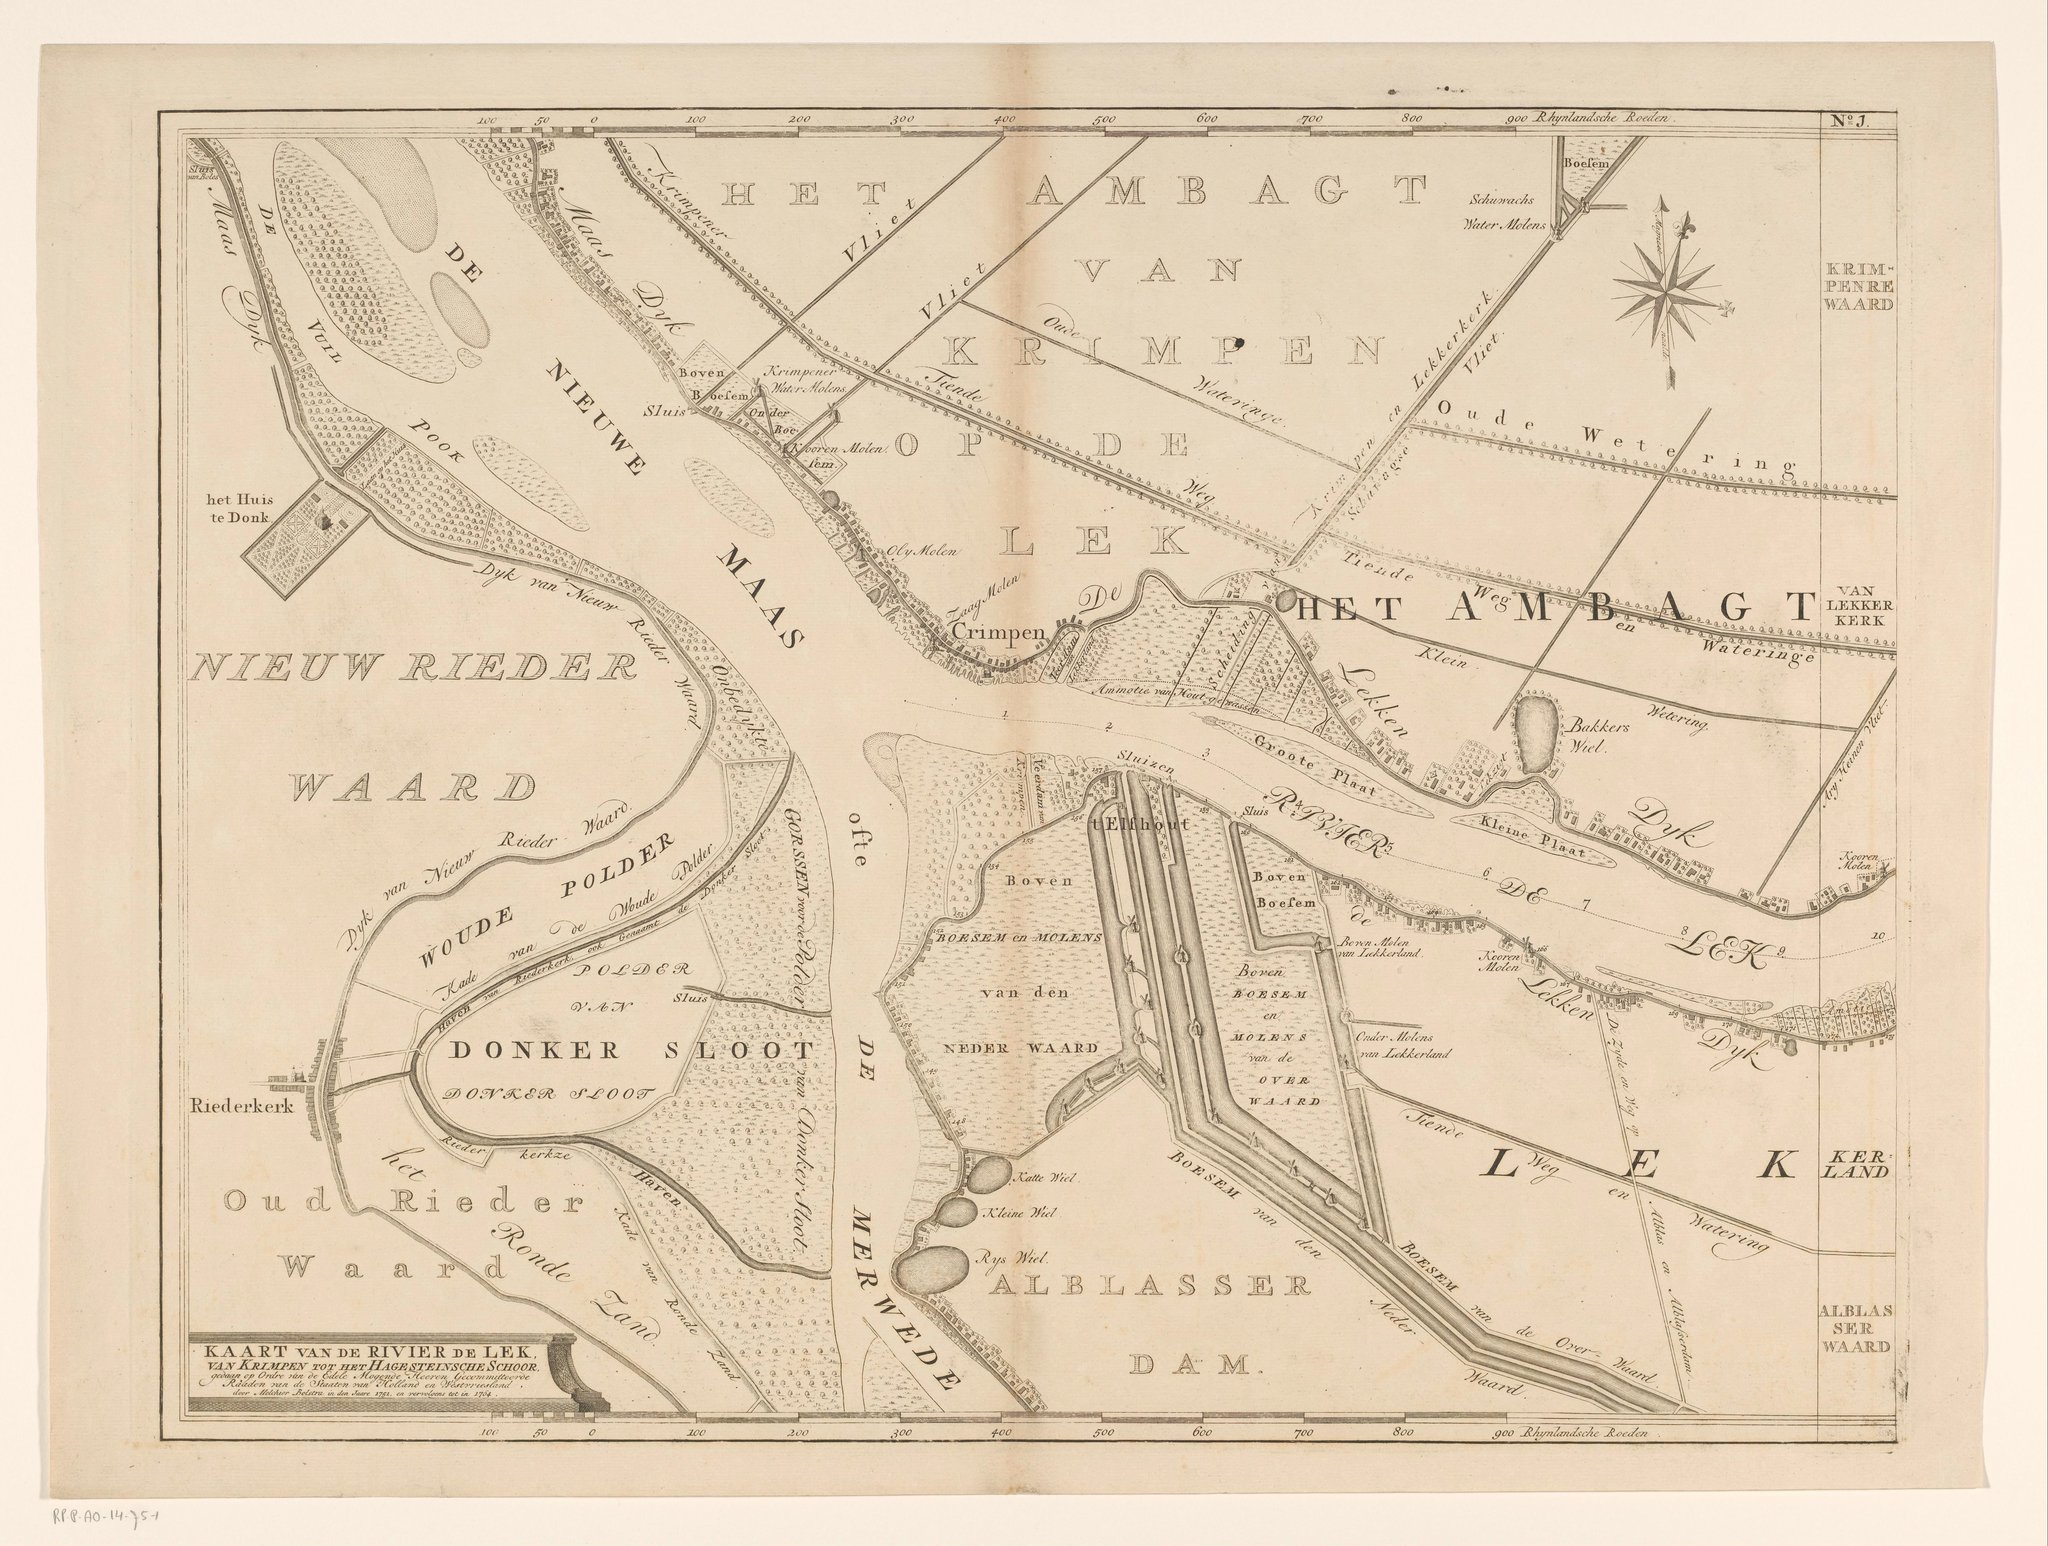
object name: map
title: Kaart van de rivier de Lek, met zyn uiterwaarden noorder en zuider dyken, van de Merwede beneden Krimpen, tot het schoor van Hagestein boven Vianen / Kaart van de rivier de Lek van Krimpen tot het Hagesteinsche Schoor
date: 1764-1765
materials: paper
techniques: engraving, etching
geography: amsterdam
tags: maps of separate countries or regions, river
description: Eerste deel van een kaart van de rivier de Lek, bestaande uit zeven delen. Rechtsboven genummerd: No. 1.